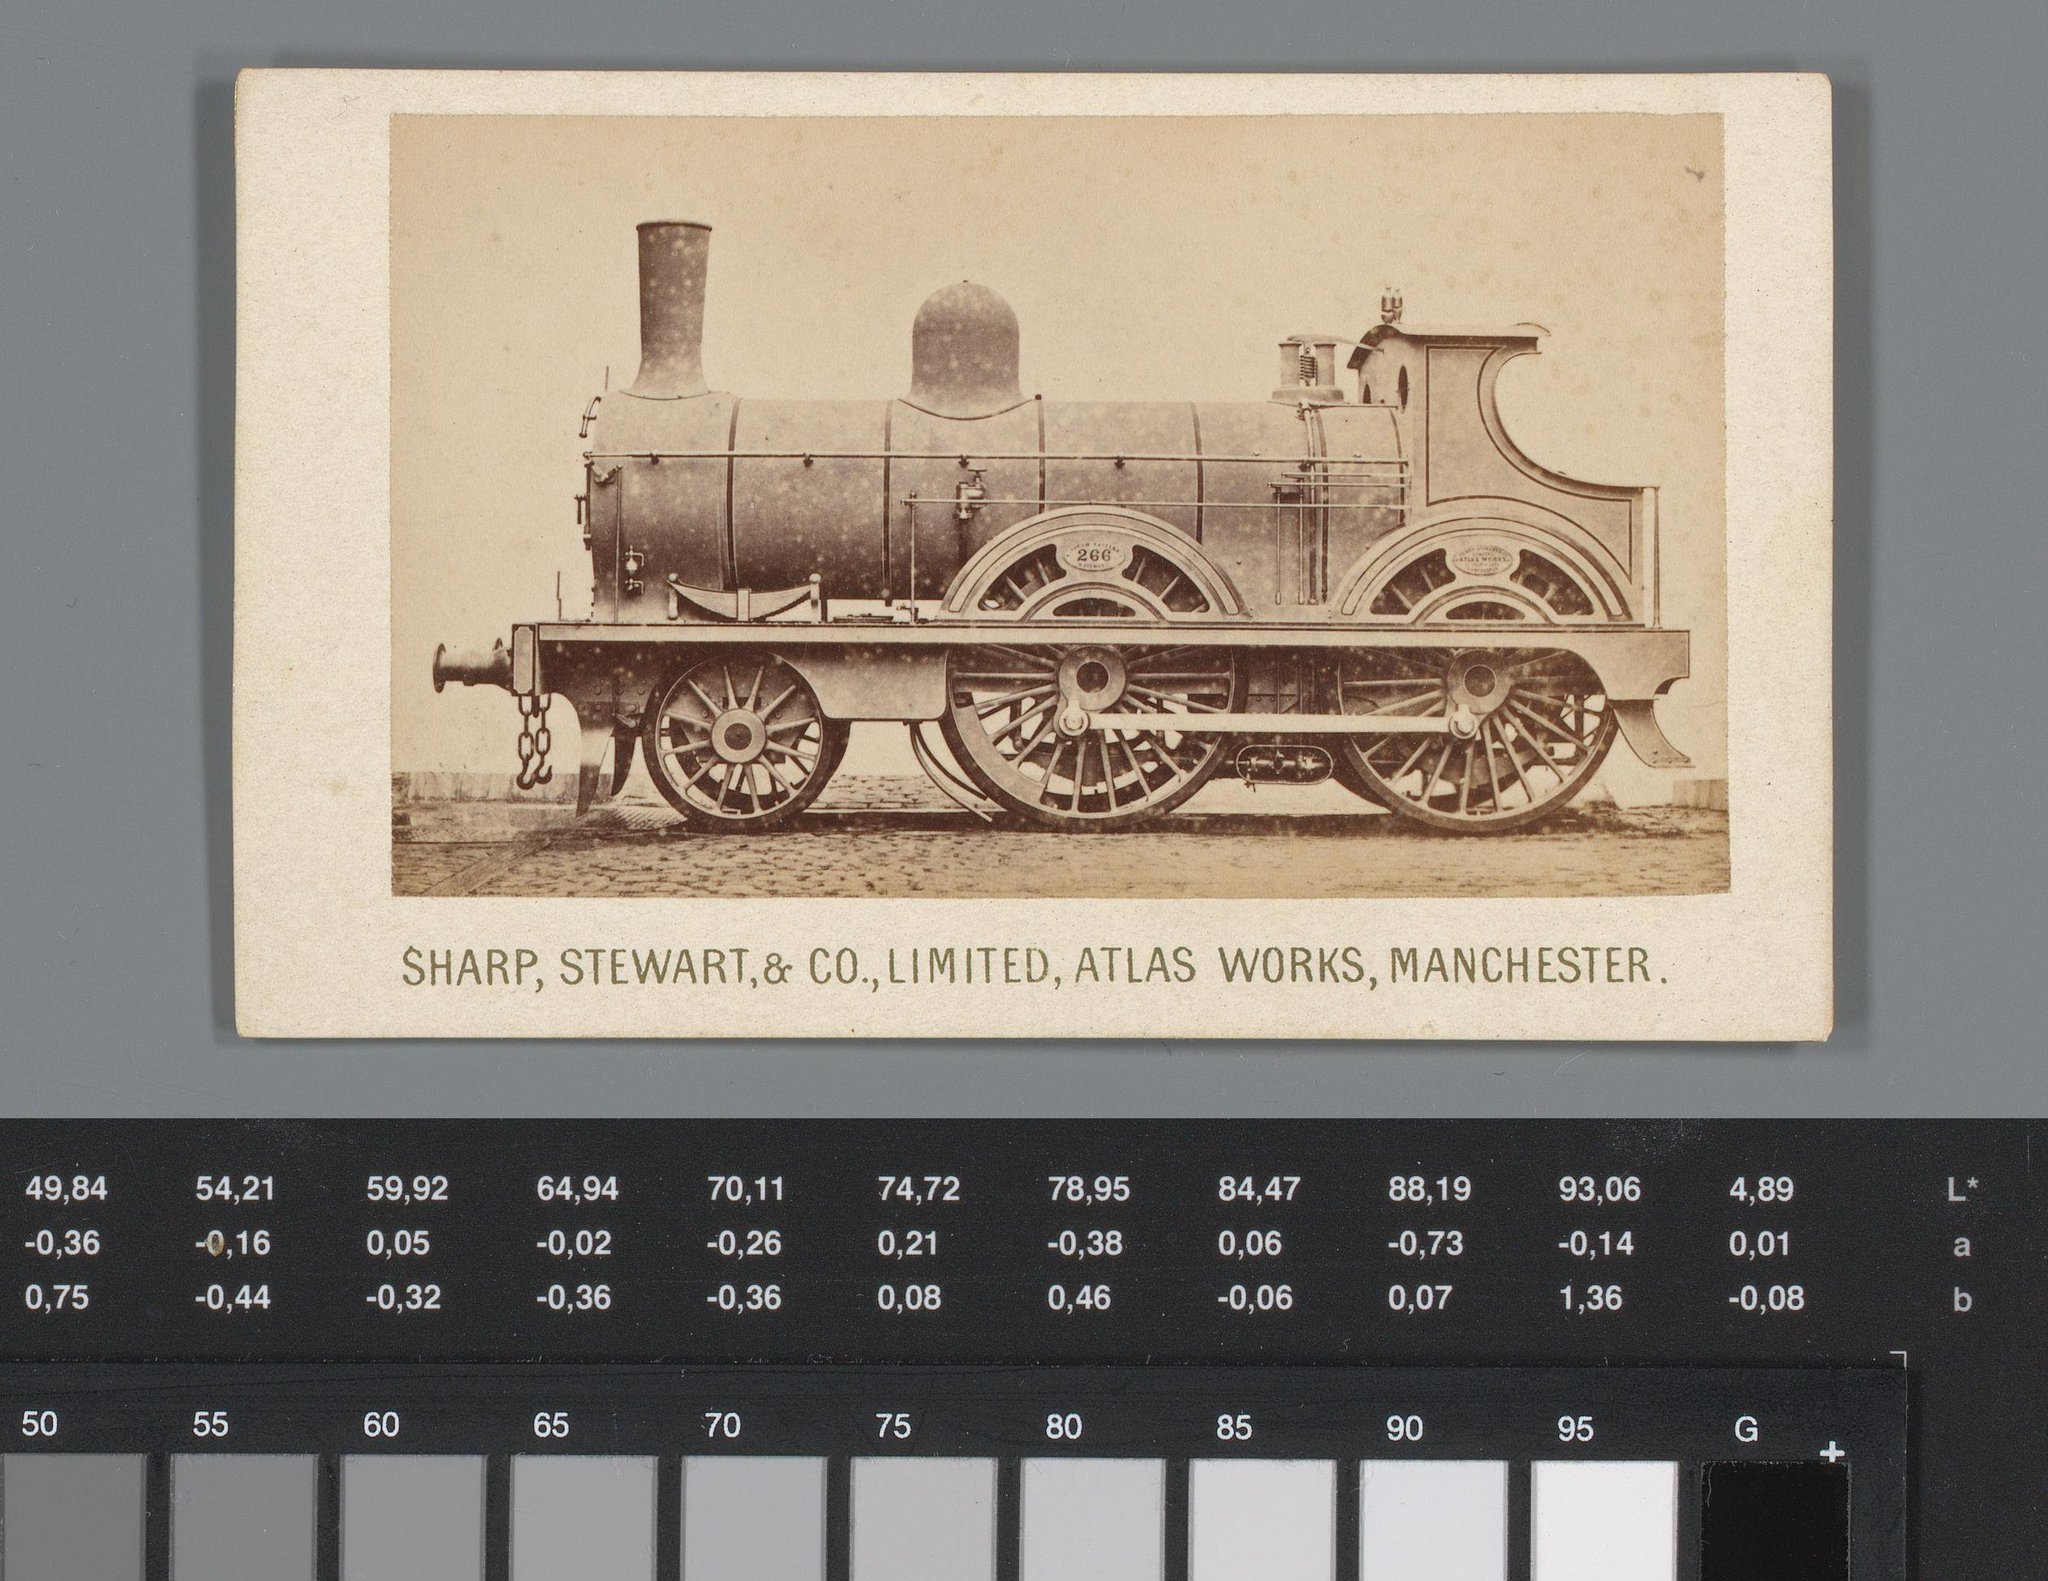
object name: carte de visite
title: Reclame voor atlassen van Sharp, Steward, & Co. te Manchester, met gezicht op een locomotief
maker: Anonymous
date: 1850-1915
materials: cardboard, photographic support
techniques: albumen print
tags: advertising, steam locomotive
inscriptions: inscription: ‘SHARP, STEWART, & CO., LIMITED, ATLAS WORKS, MANCHESTER.’